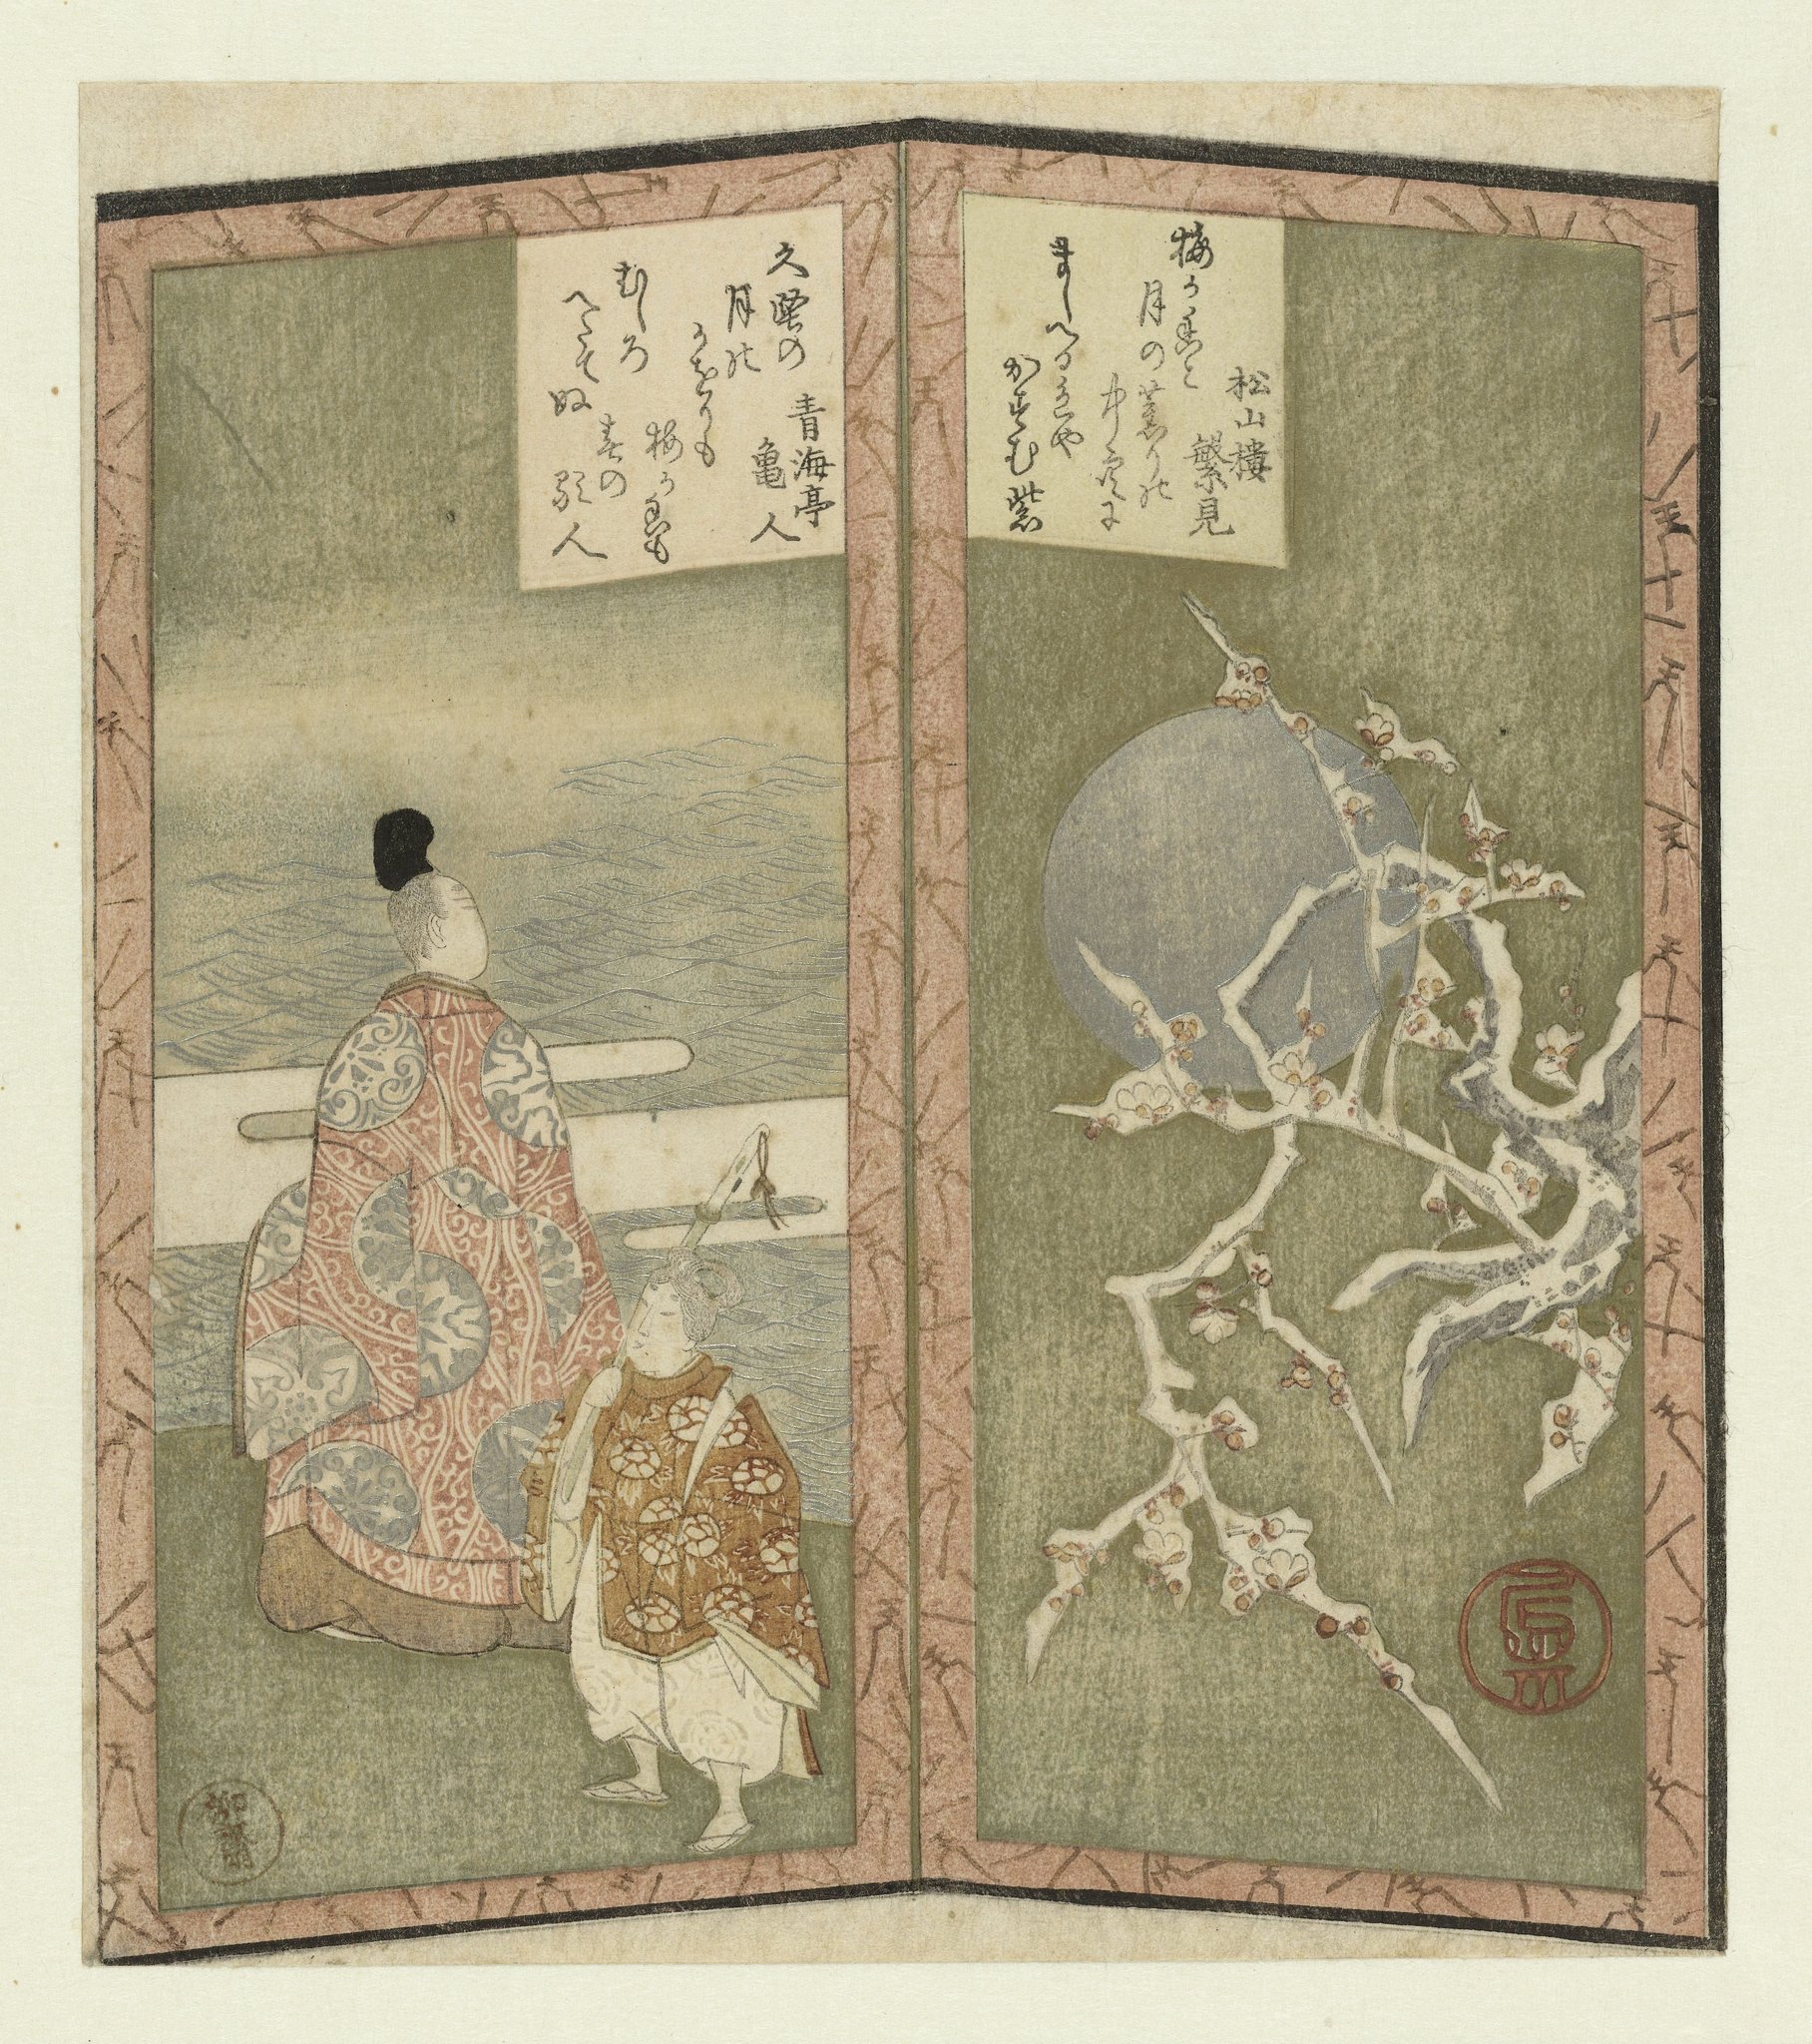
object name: surimono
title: Plum Blossoms and Poet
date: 1825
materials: paper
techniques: blind stamped, woodcut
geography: japan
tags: screen, folding screen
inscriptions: collector's mark, verso, stamped: Lugt 2228, collector's mark, passe-partout, bottom left, printed: JABdH with a rooster.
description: Een surimono is een luxe uitgevoerde prent waarop beeld met één of meerdere gedichten gecombineerd is. Bij het drukken van een surimono werd vaak gebruik gemaakt van dikker papier, blinddruk en metaal pigmenten, zoals koper- en zilverpoeder. De prenten werden vaak in opdracht van dichters gemaakt en als exclusief geschenk aan vrienden en relaties gegeven.